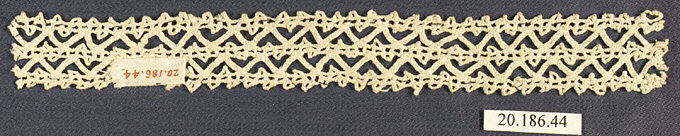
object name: strip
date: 1501-1600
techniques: lace